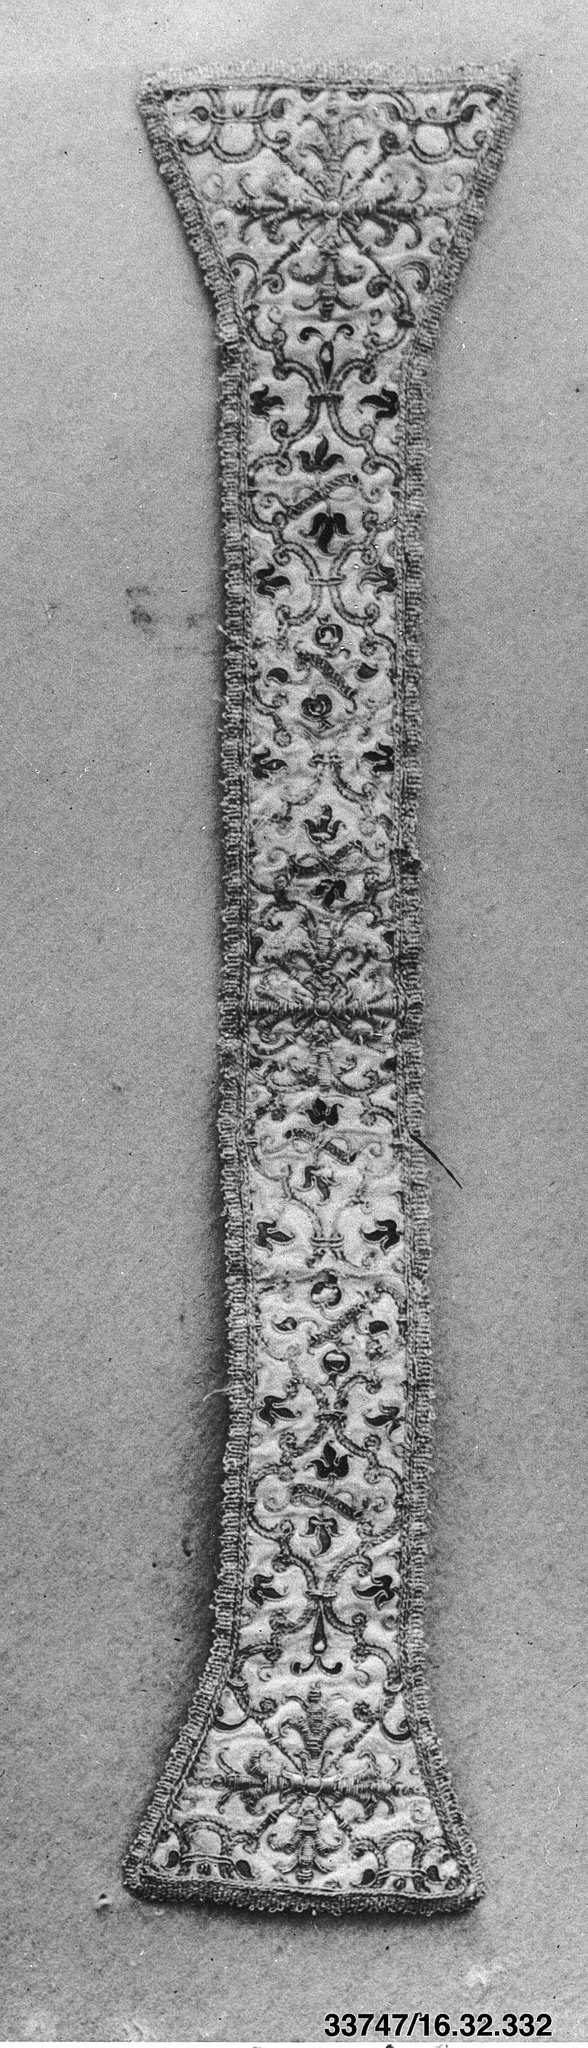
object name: maniple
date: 1501-1600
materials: metal thread, silk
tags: flowers